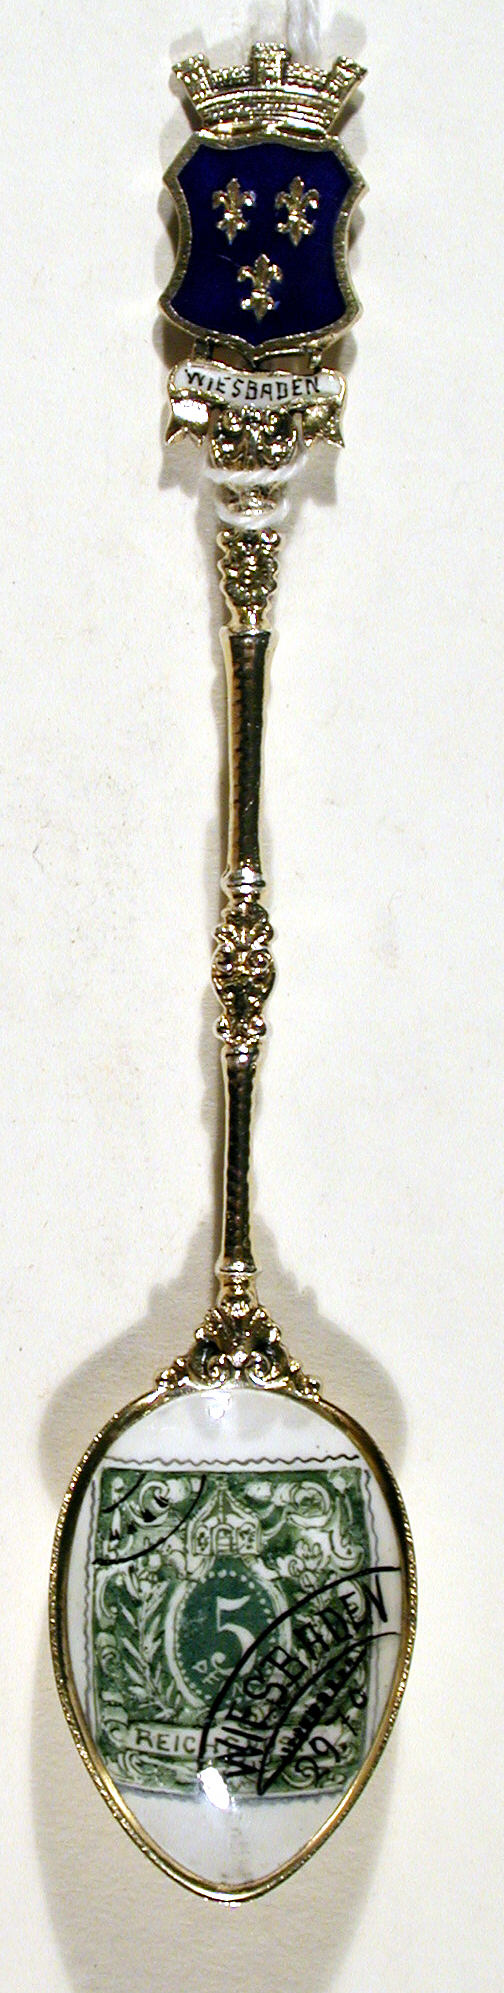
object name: souvenir spoon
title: Souvenir spoon with green postage stamp and postmark for Wiesbaden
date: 1867-1900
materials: silver gilt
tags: coat of arms